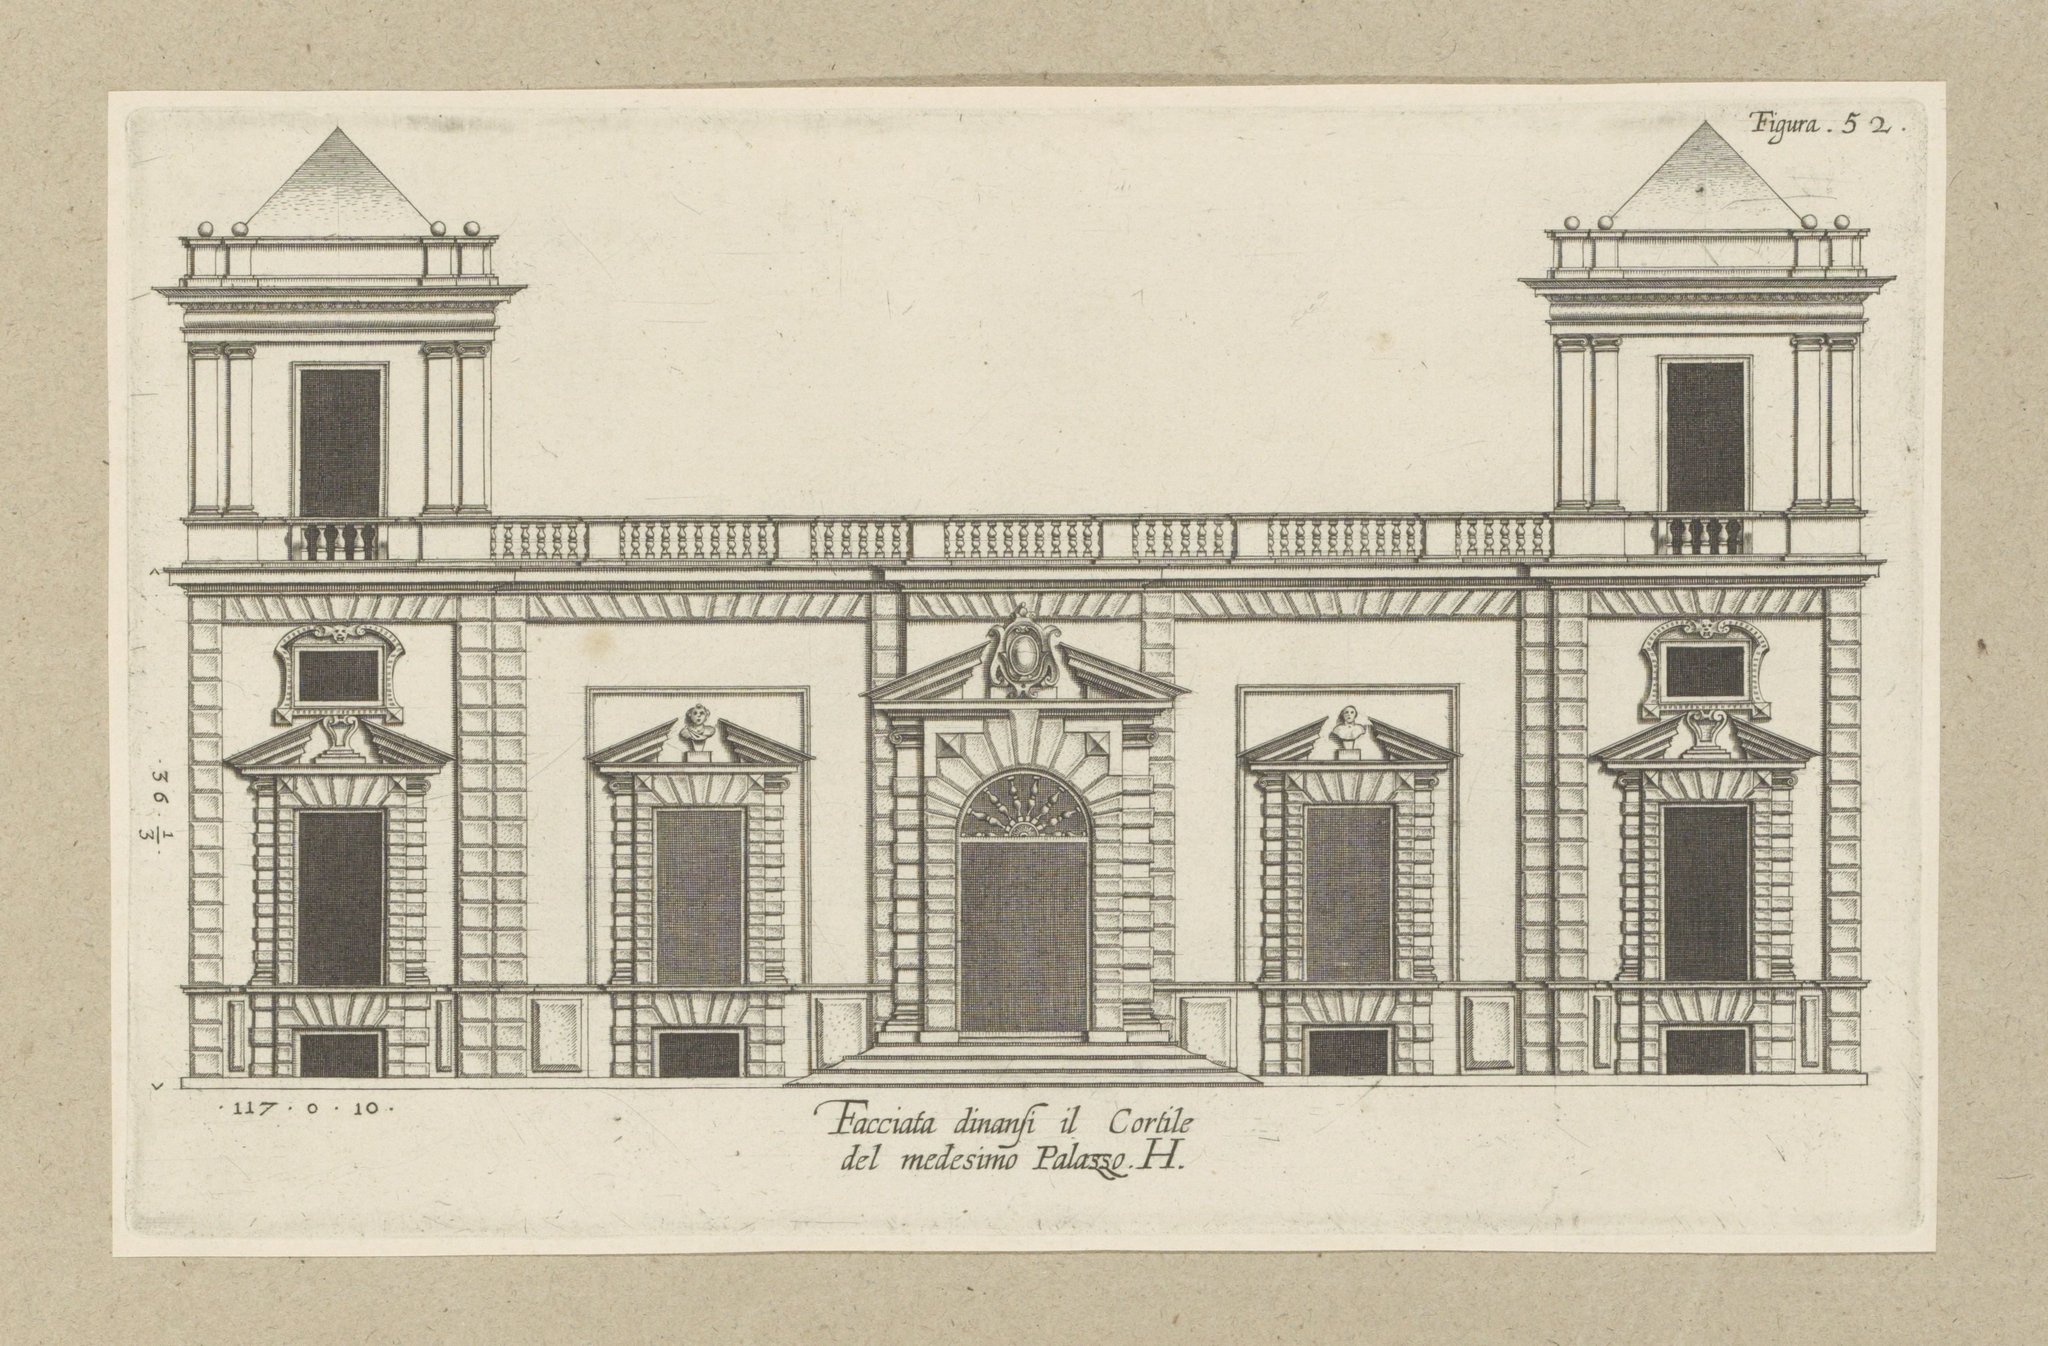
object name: album leaf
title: Facciata dinansi il Cortile / del medesimo Palazzo. H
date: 1622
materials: paper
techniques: engraving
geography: antwerp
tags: hôtel, i.e. small palace in city, façade (of house or building), exterior ~ architectural design or model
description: Deze prent maakt deel uit van een album.